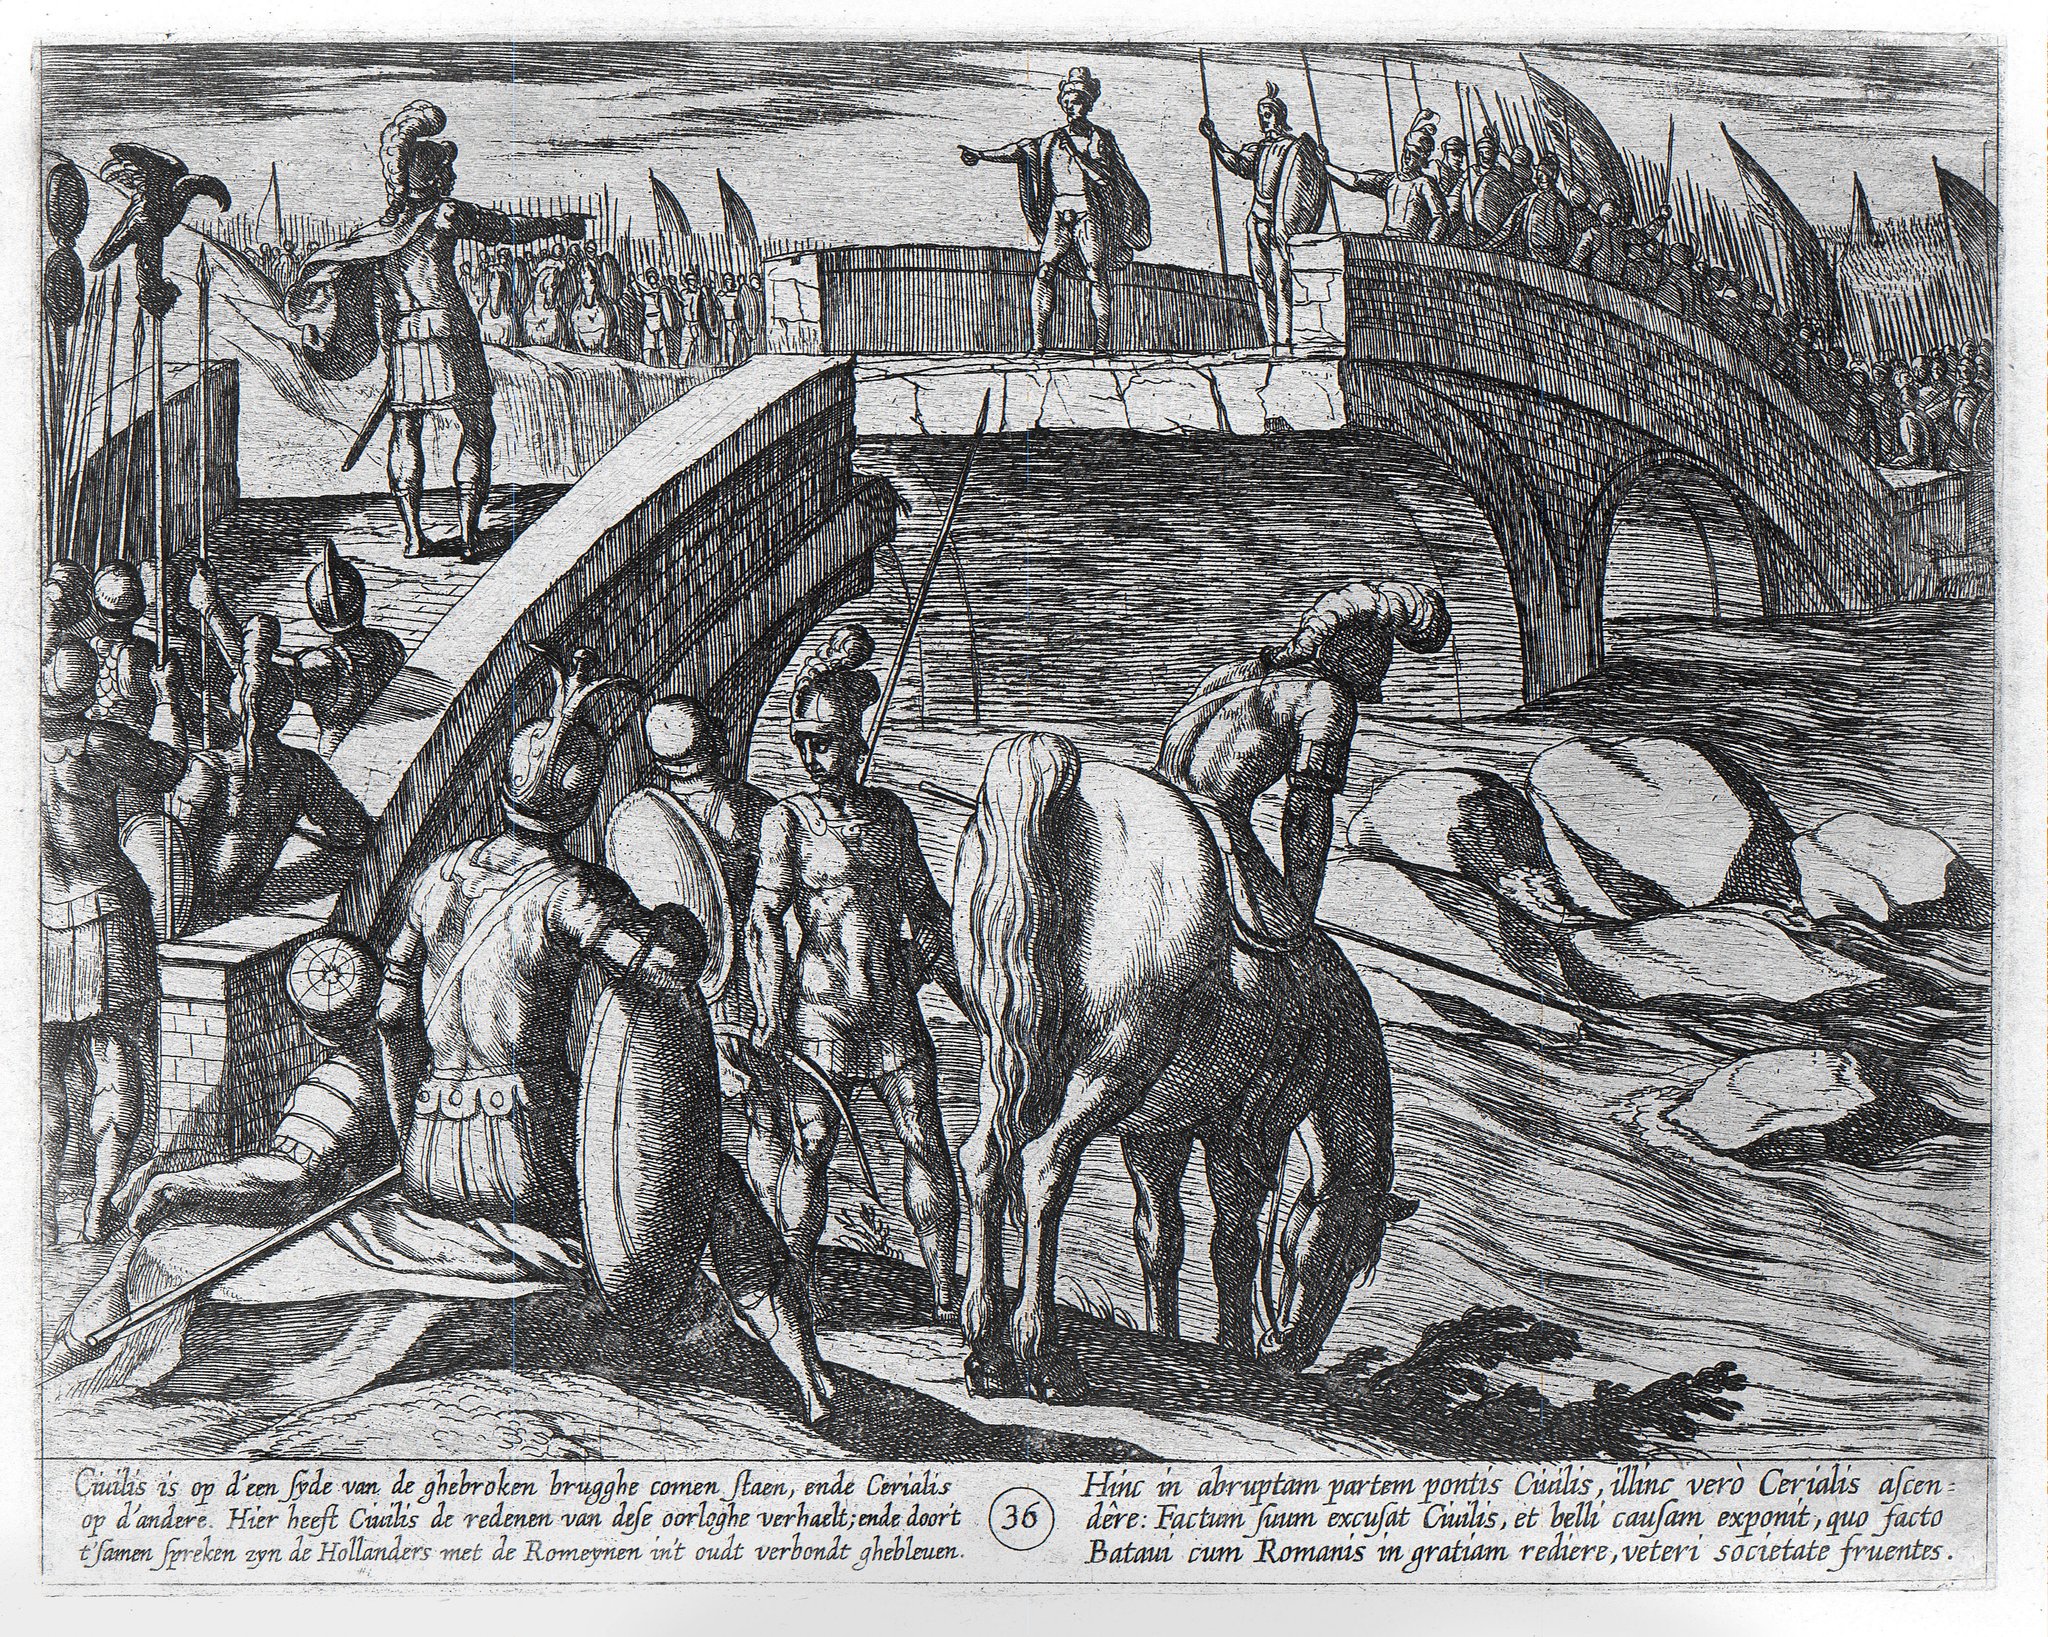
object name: print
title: De Bataafse oorlogen tegen de Romeinen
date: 1611-1612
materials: paper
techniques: etching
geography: southern netherlands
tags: the soldier; the soldier's life, (story of) julius claudius civilis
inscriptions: collector's mark: Lugt 240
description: Een geheime ontmoeting tussen Julius Civilis en andere leiders in een woning in Colonia Agrippinensis. Onderschrift in het Nederlands en in het Latijn.